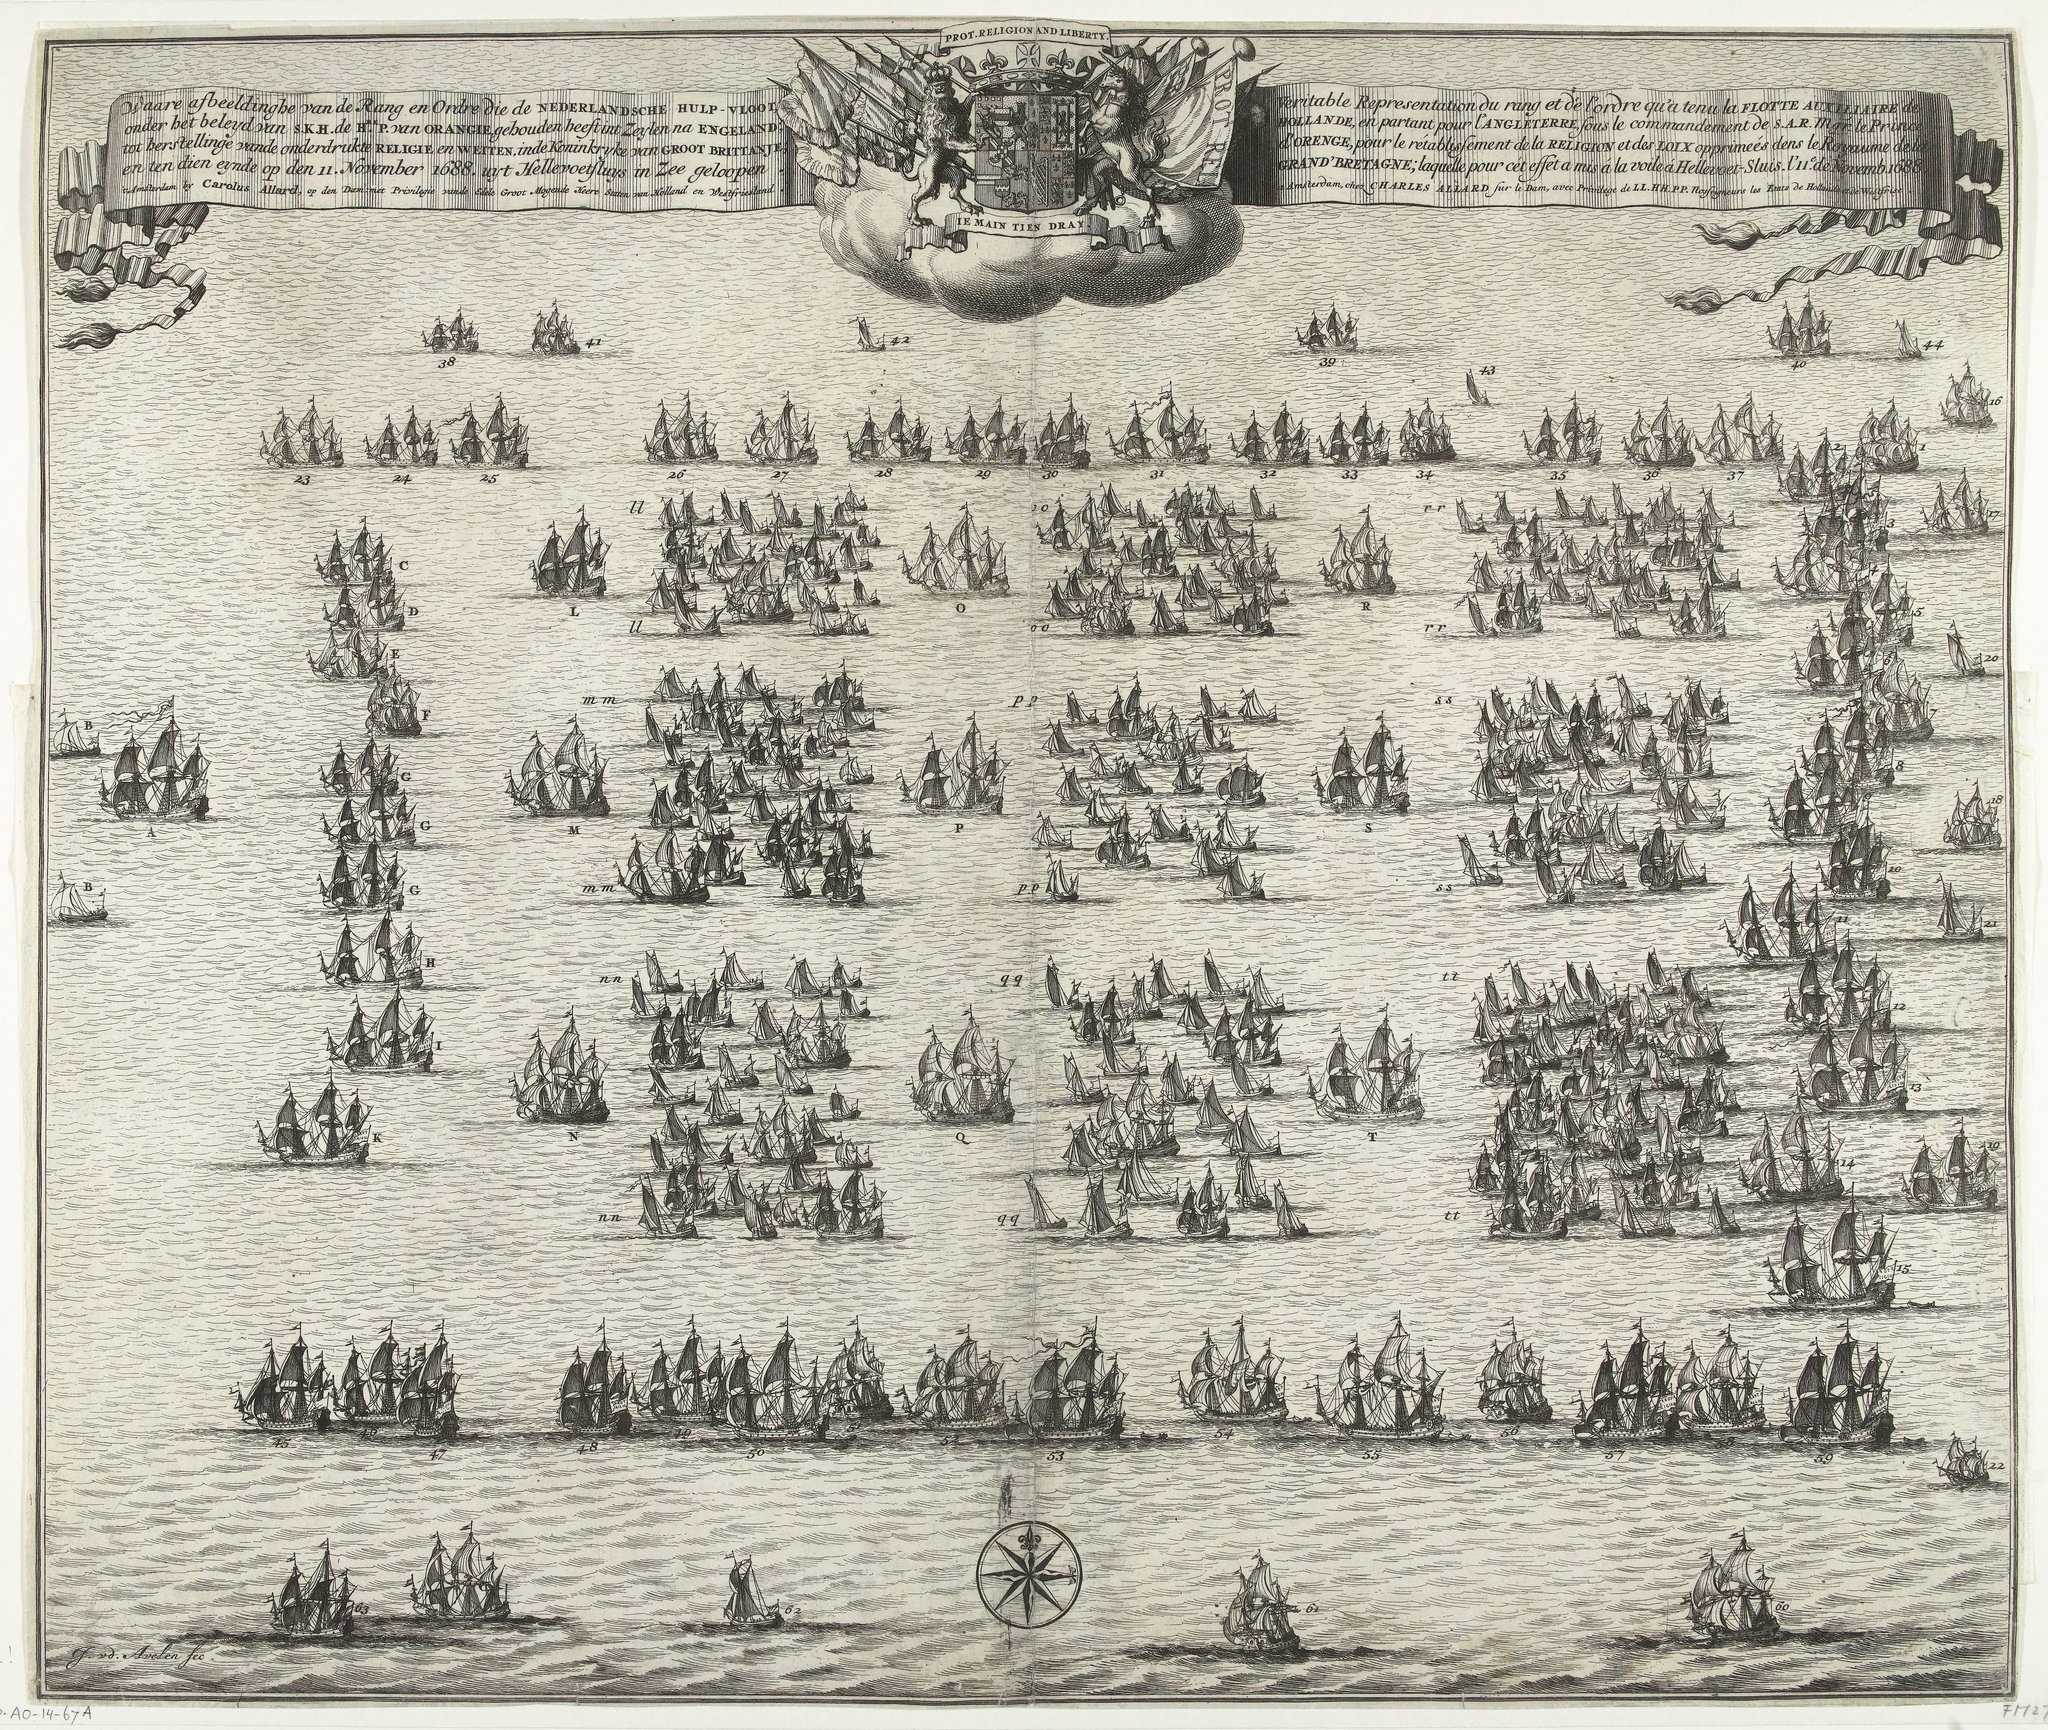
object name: print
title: Formatie van de vloot waarmee Willem III naar Engeland is gevaren, 1688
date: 1688-1689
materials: paper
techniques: etching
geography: northern netherlands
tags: the hague, william iii (prince of orange and king of england, scotland, and ireland), warfare; military affairs (+ sailing-ships)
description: De formatie van de vloot waarmee prins Willem III vanuit Hellevoetsluis naar Engeland is vertrokken, 11 november 1688. Bovenaan het wapen van de stadhouder-koning Willem III met de spreuken 'Prot. Religion and Liberty' en 'Je Maintiendray'. In deze staat middenonderaan een windroos. Bij de prent behoort een tekstblad met de legenda.